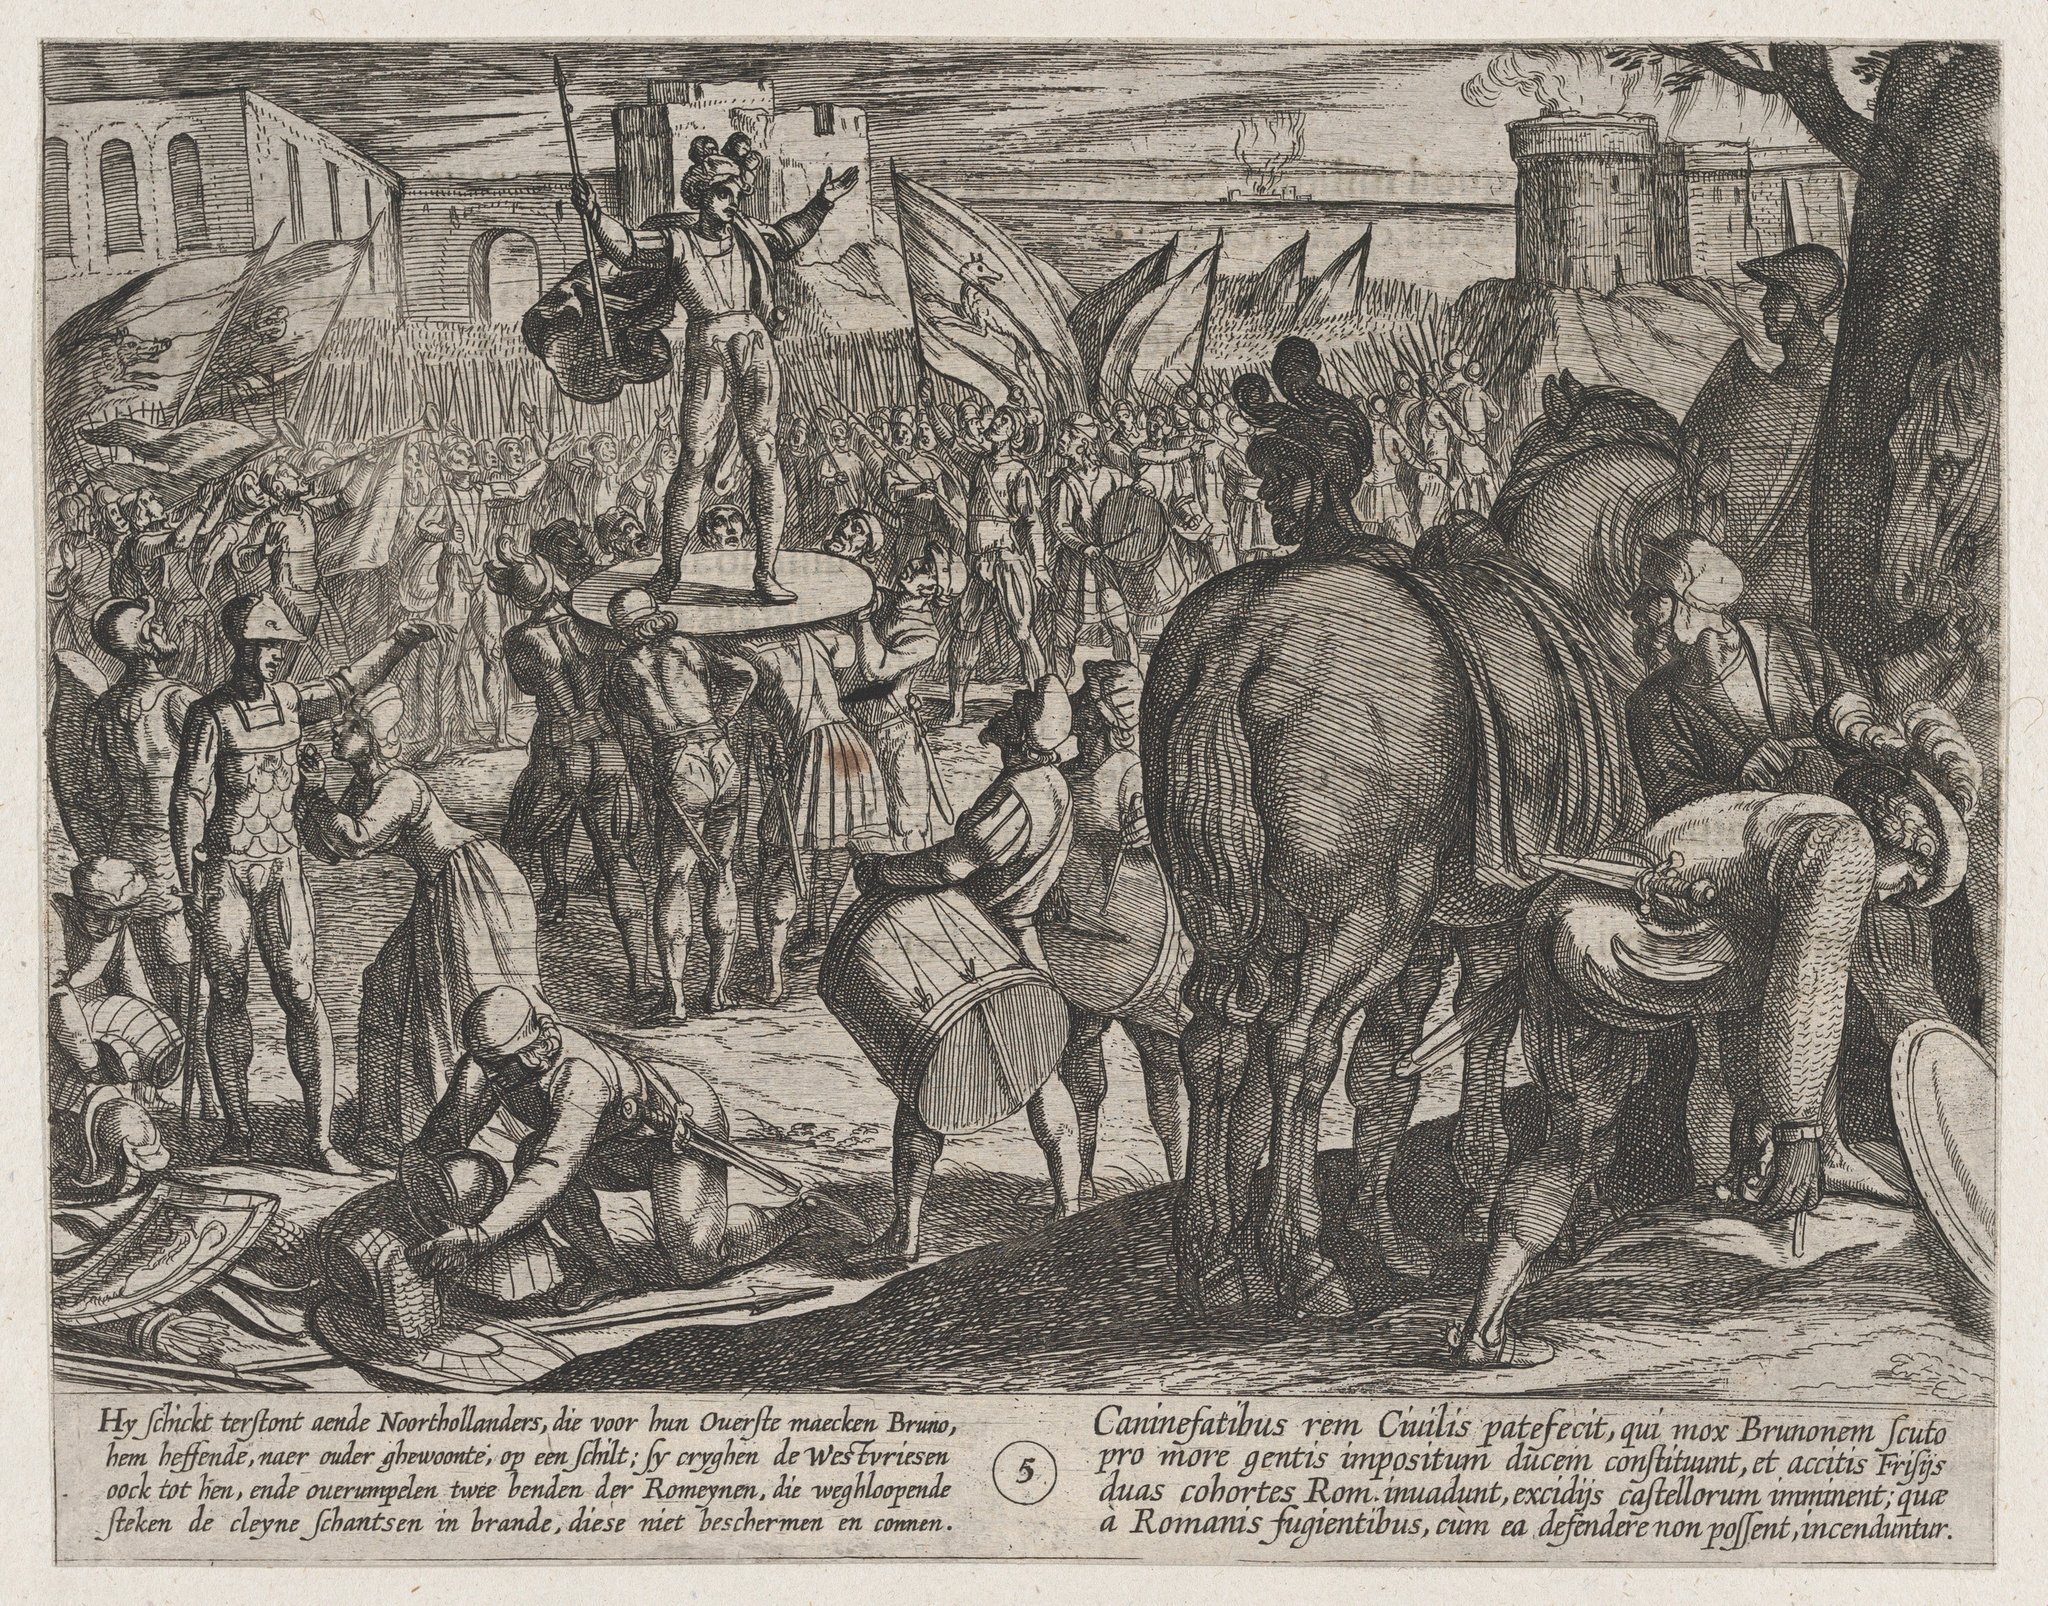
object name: print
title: Plate 5: Bruno Appointed Leader of the Caninefates, from The War of the Romans Against the Batavians (Romanorvm et Batavorvm societas)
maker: antonio tempesta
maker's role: artist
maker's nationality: italian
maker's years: 1555-1630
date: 1611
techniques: etching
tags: wars,soldiers,horses